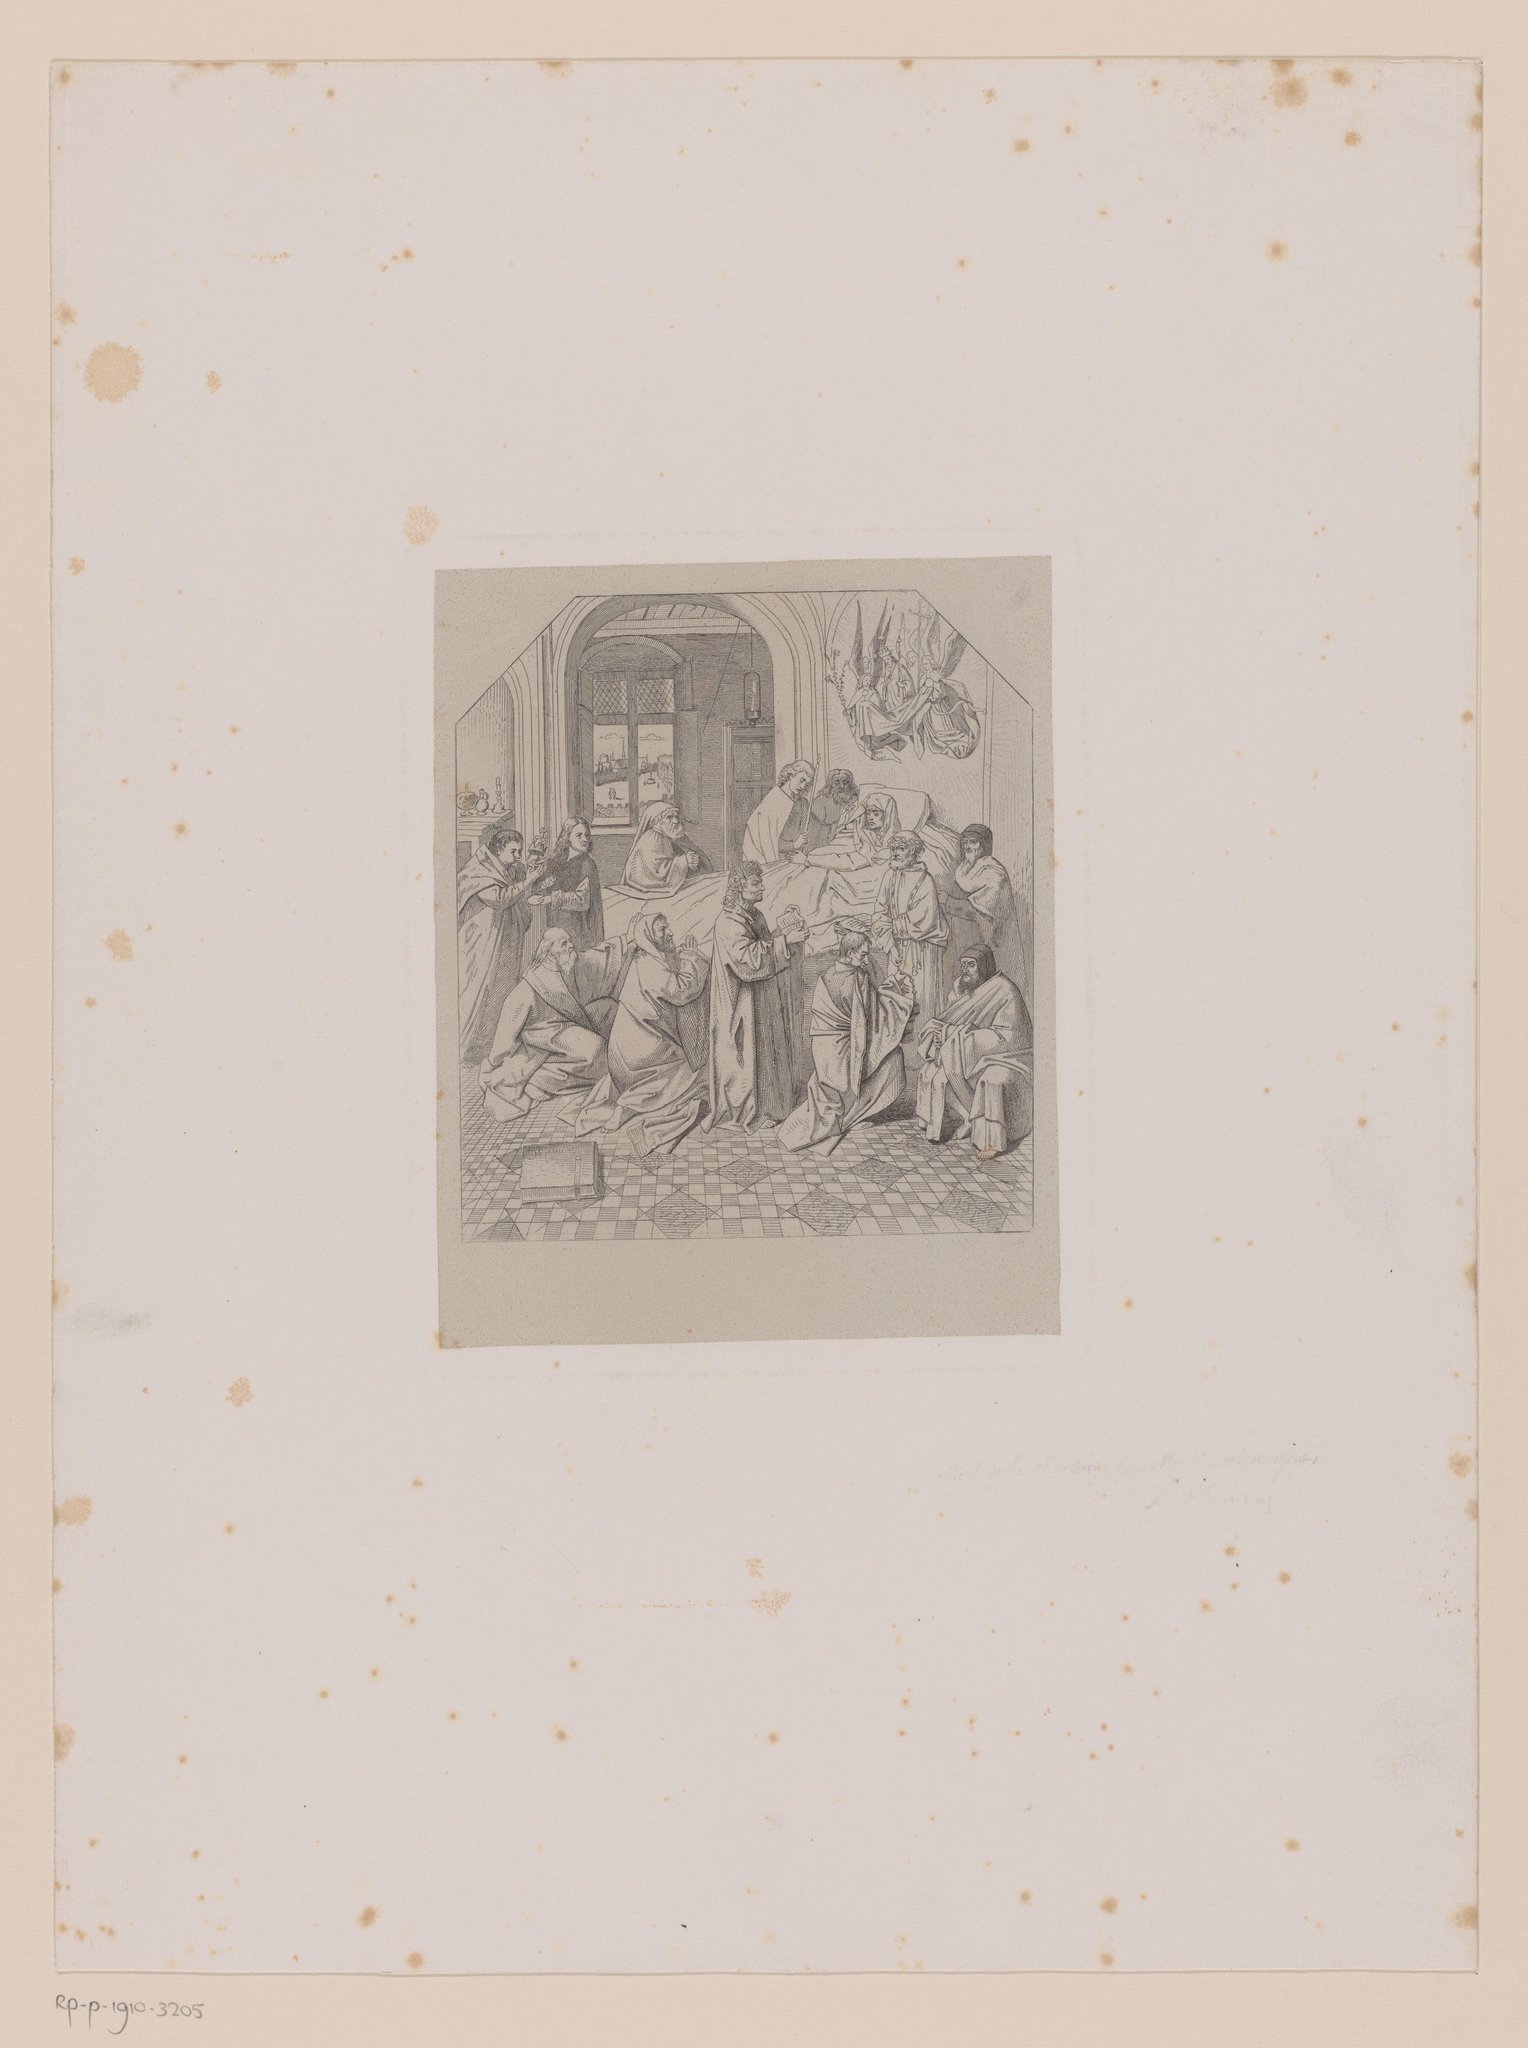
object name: print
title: Maria op haar sterfbed omringd door de apostelen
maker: léopold flameng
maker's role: print maker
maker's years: 1831-1911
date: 1859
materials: paper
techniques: etching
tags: the dormition: mary on her deathbed; the apostles are gathered around her (john the evangelist may be shown sleeping or dreaming)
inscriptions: collector's mark: Lugt 2228